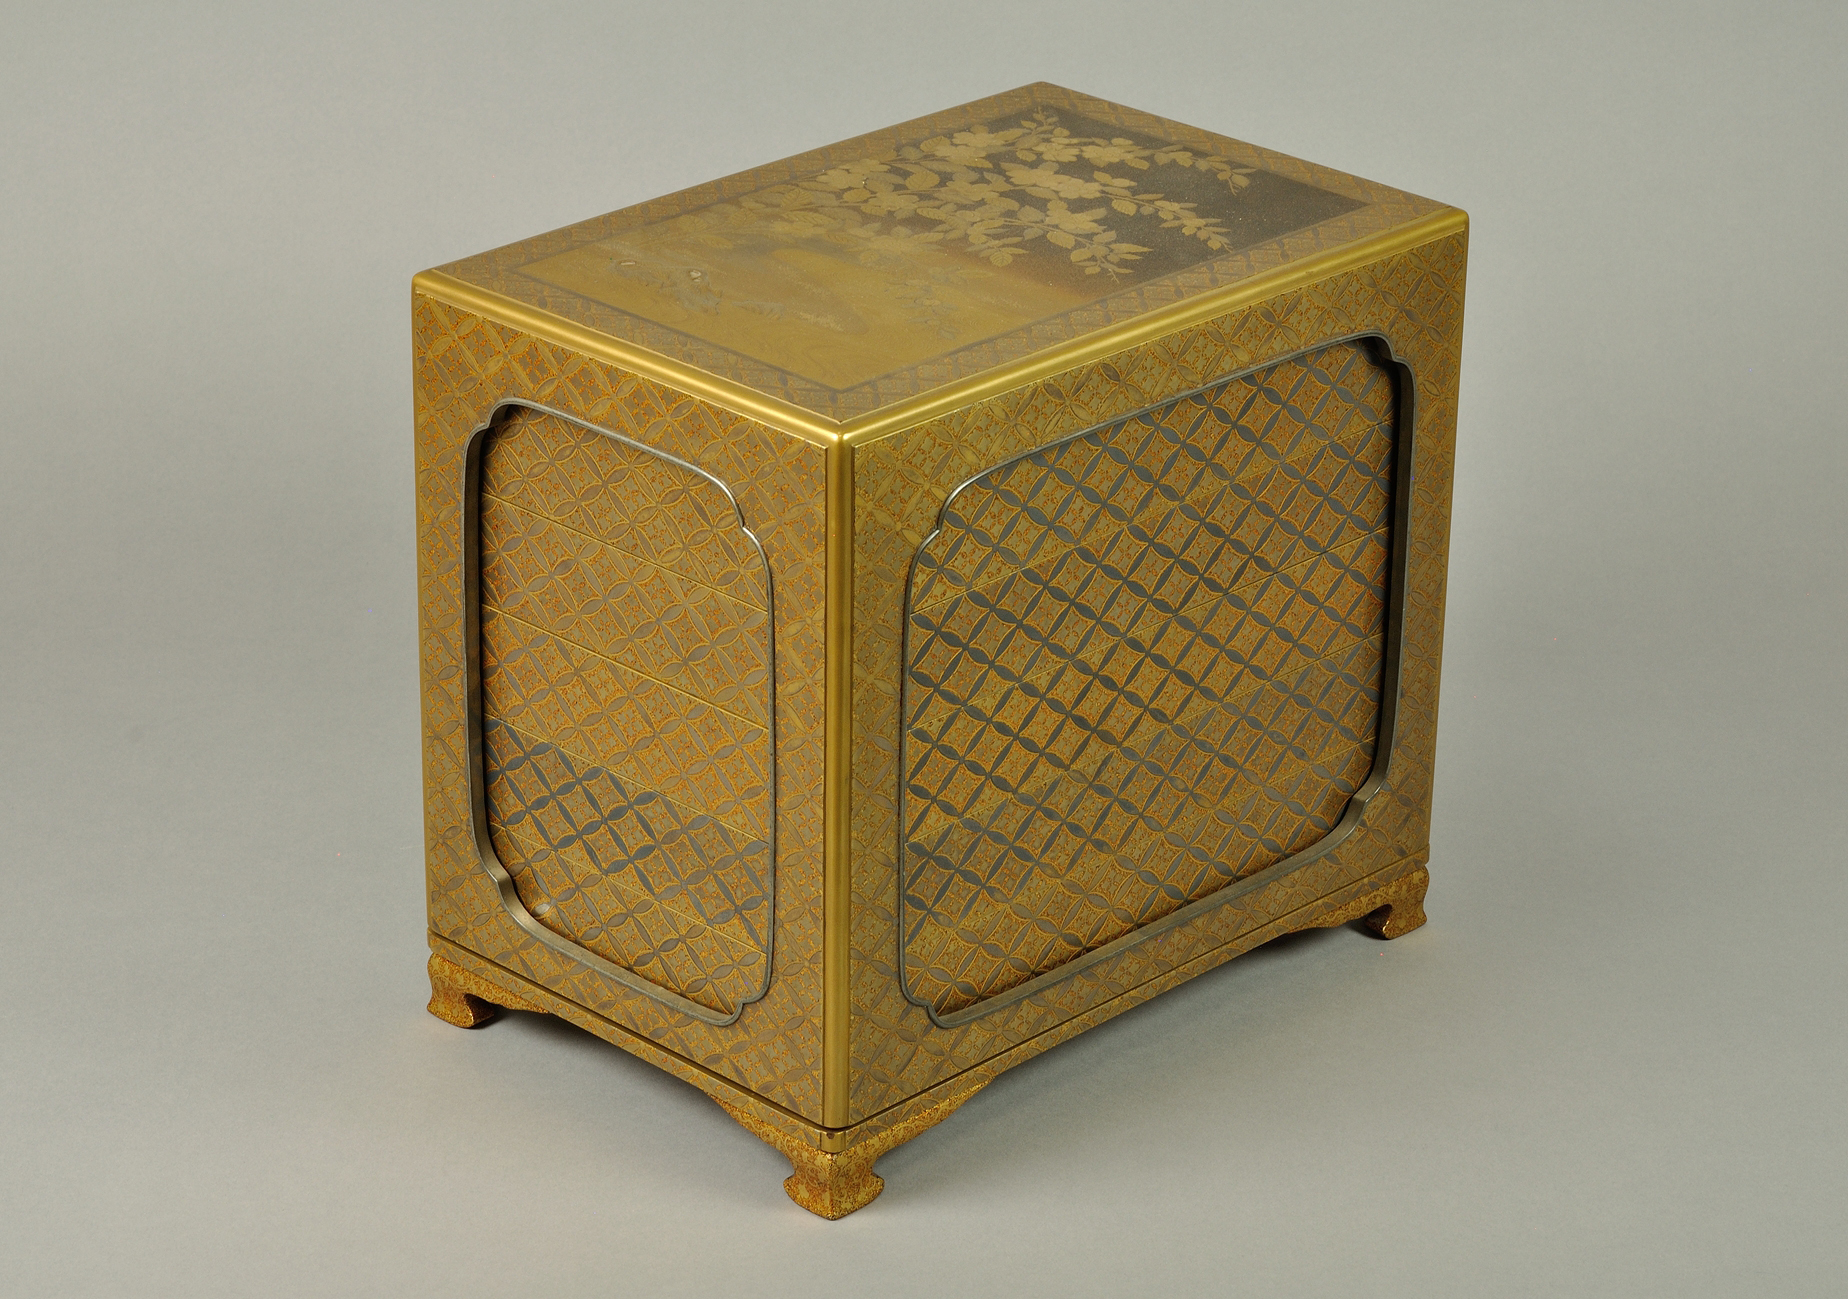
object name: writing box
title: Set of Five Writing Boxes with Japanese Globeflowers, Plum Blossoms, and Interlaced Roundels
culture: japanese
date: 1767-1833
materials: gold, gold foil, silver, wood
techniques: hiramakie, lacquer